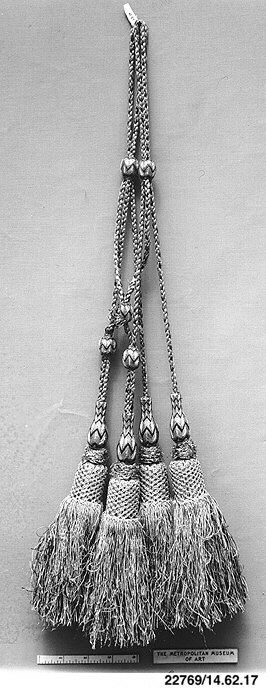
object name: tassel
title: Two pairs of tassels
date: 1701-1900